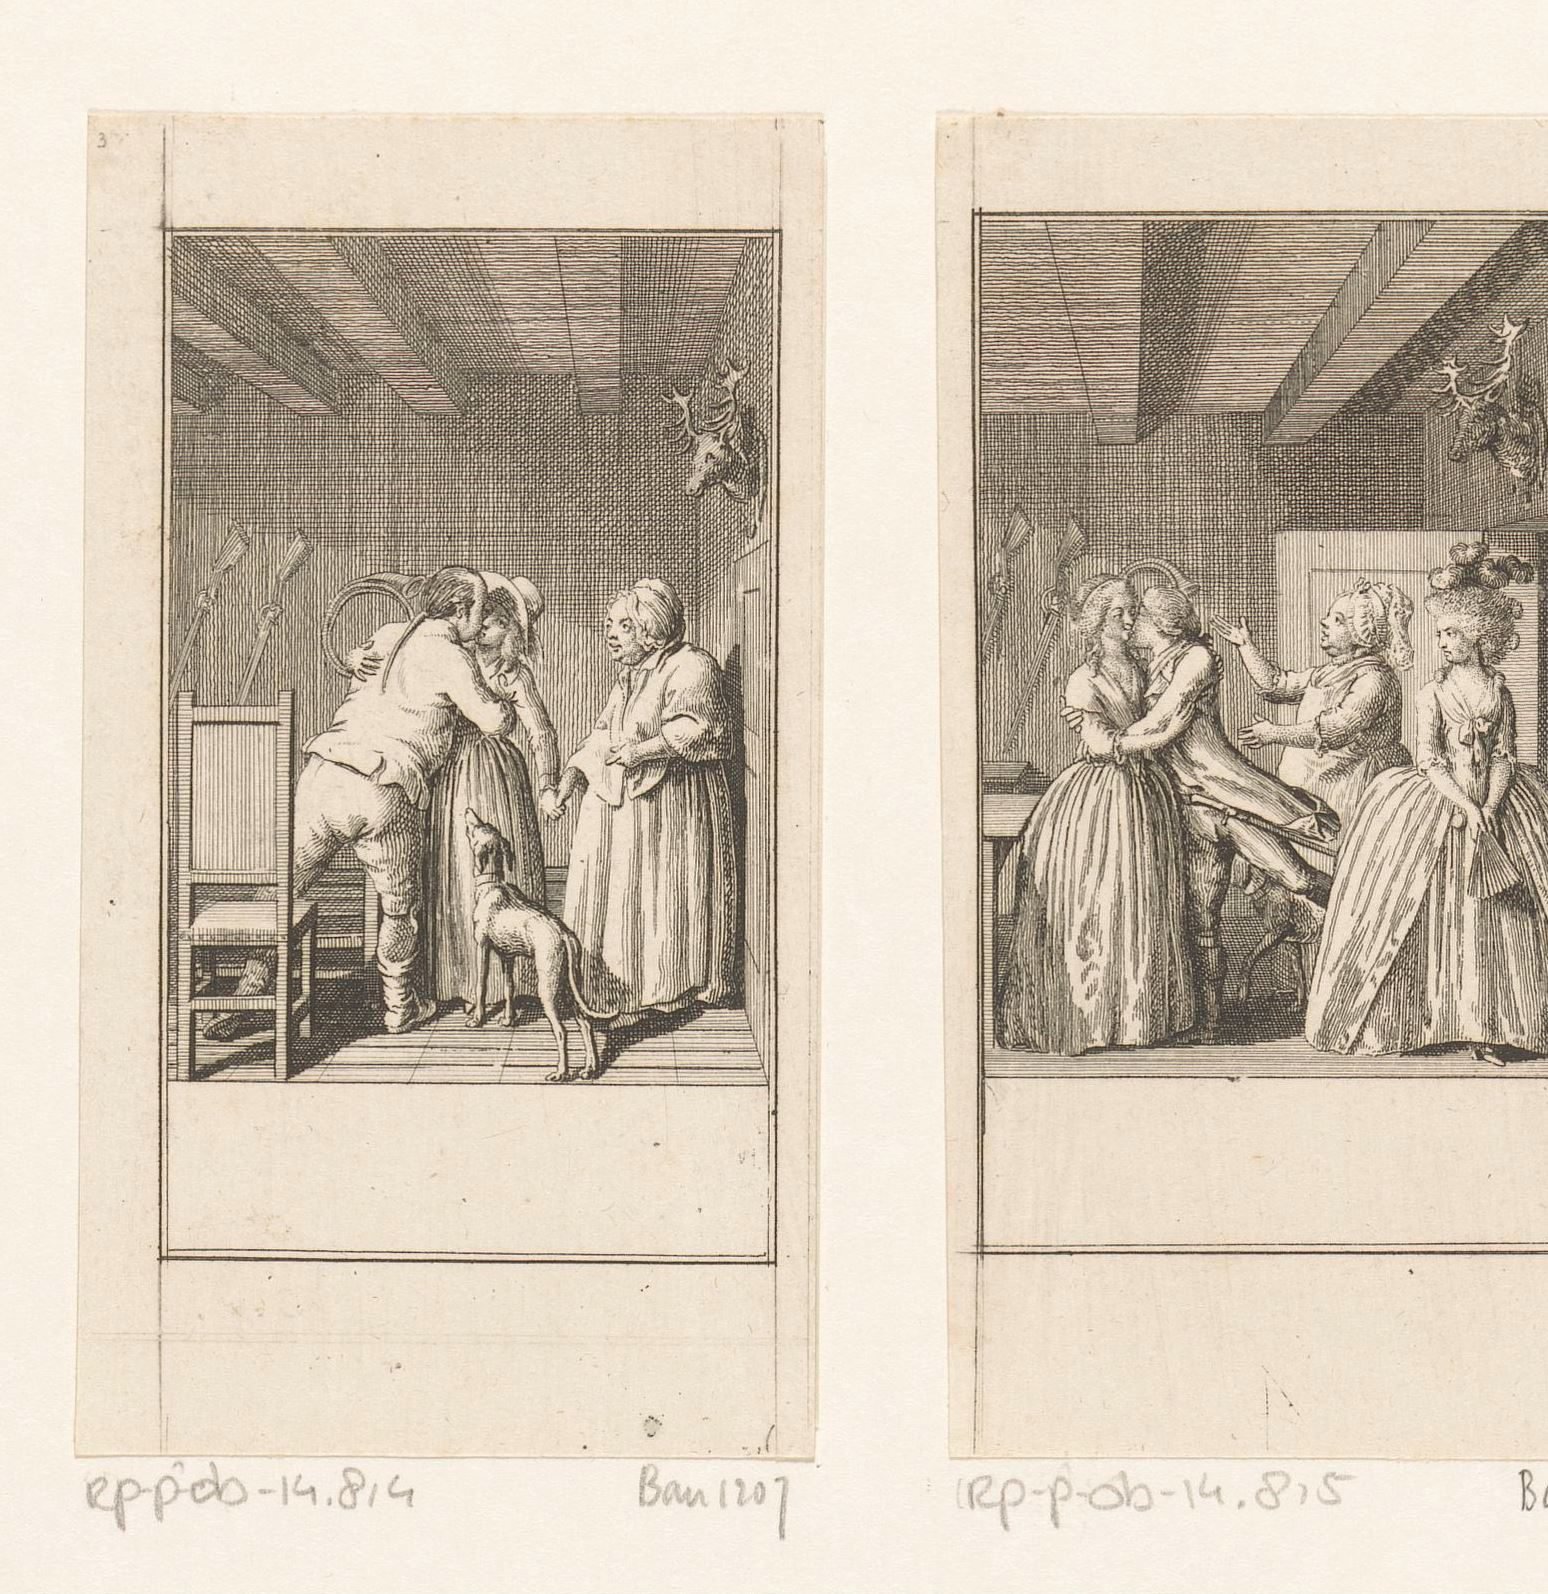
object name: print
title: Friederike wordt door zijn vrouw aan de jager voorgesteld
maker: daniel nikolaus chodowiecki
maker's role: draughtsman, print maker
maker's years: 1726-1801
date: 1786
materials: paper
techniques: etching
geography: berlin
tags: literature, hunter, embracing each other, kissing, dog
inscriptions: collector's mark: Lugt 2228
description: Vervaardigd voor August Wilhelm Ifflands 'Die Jäger'. Latere staat gebruikt voor: Berliner genealogischen Calender auf das Jahr 1787. Berlijn: s.n., 1786.